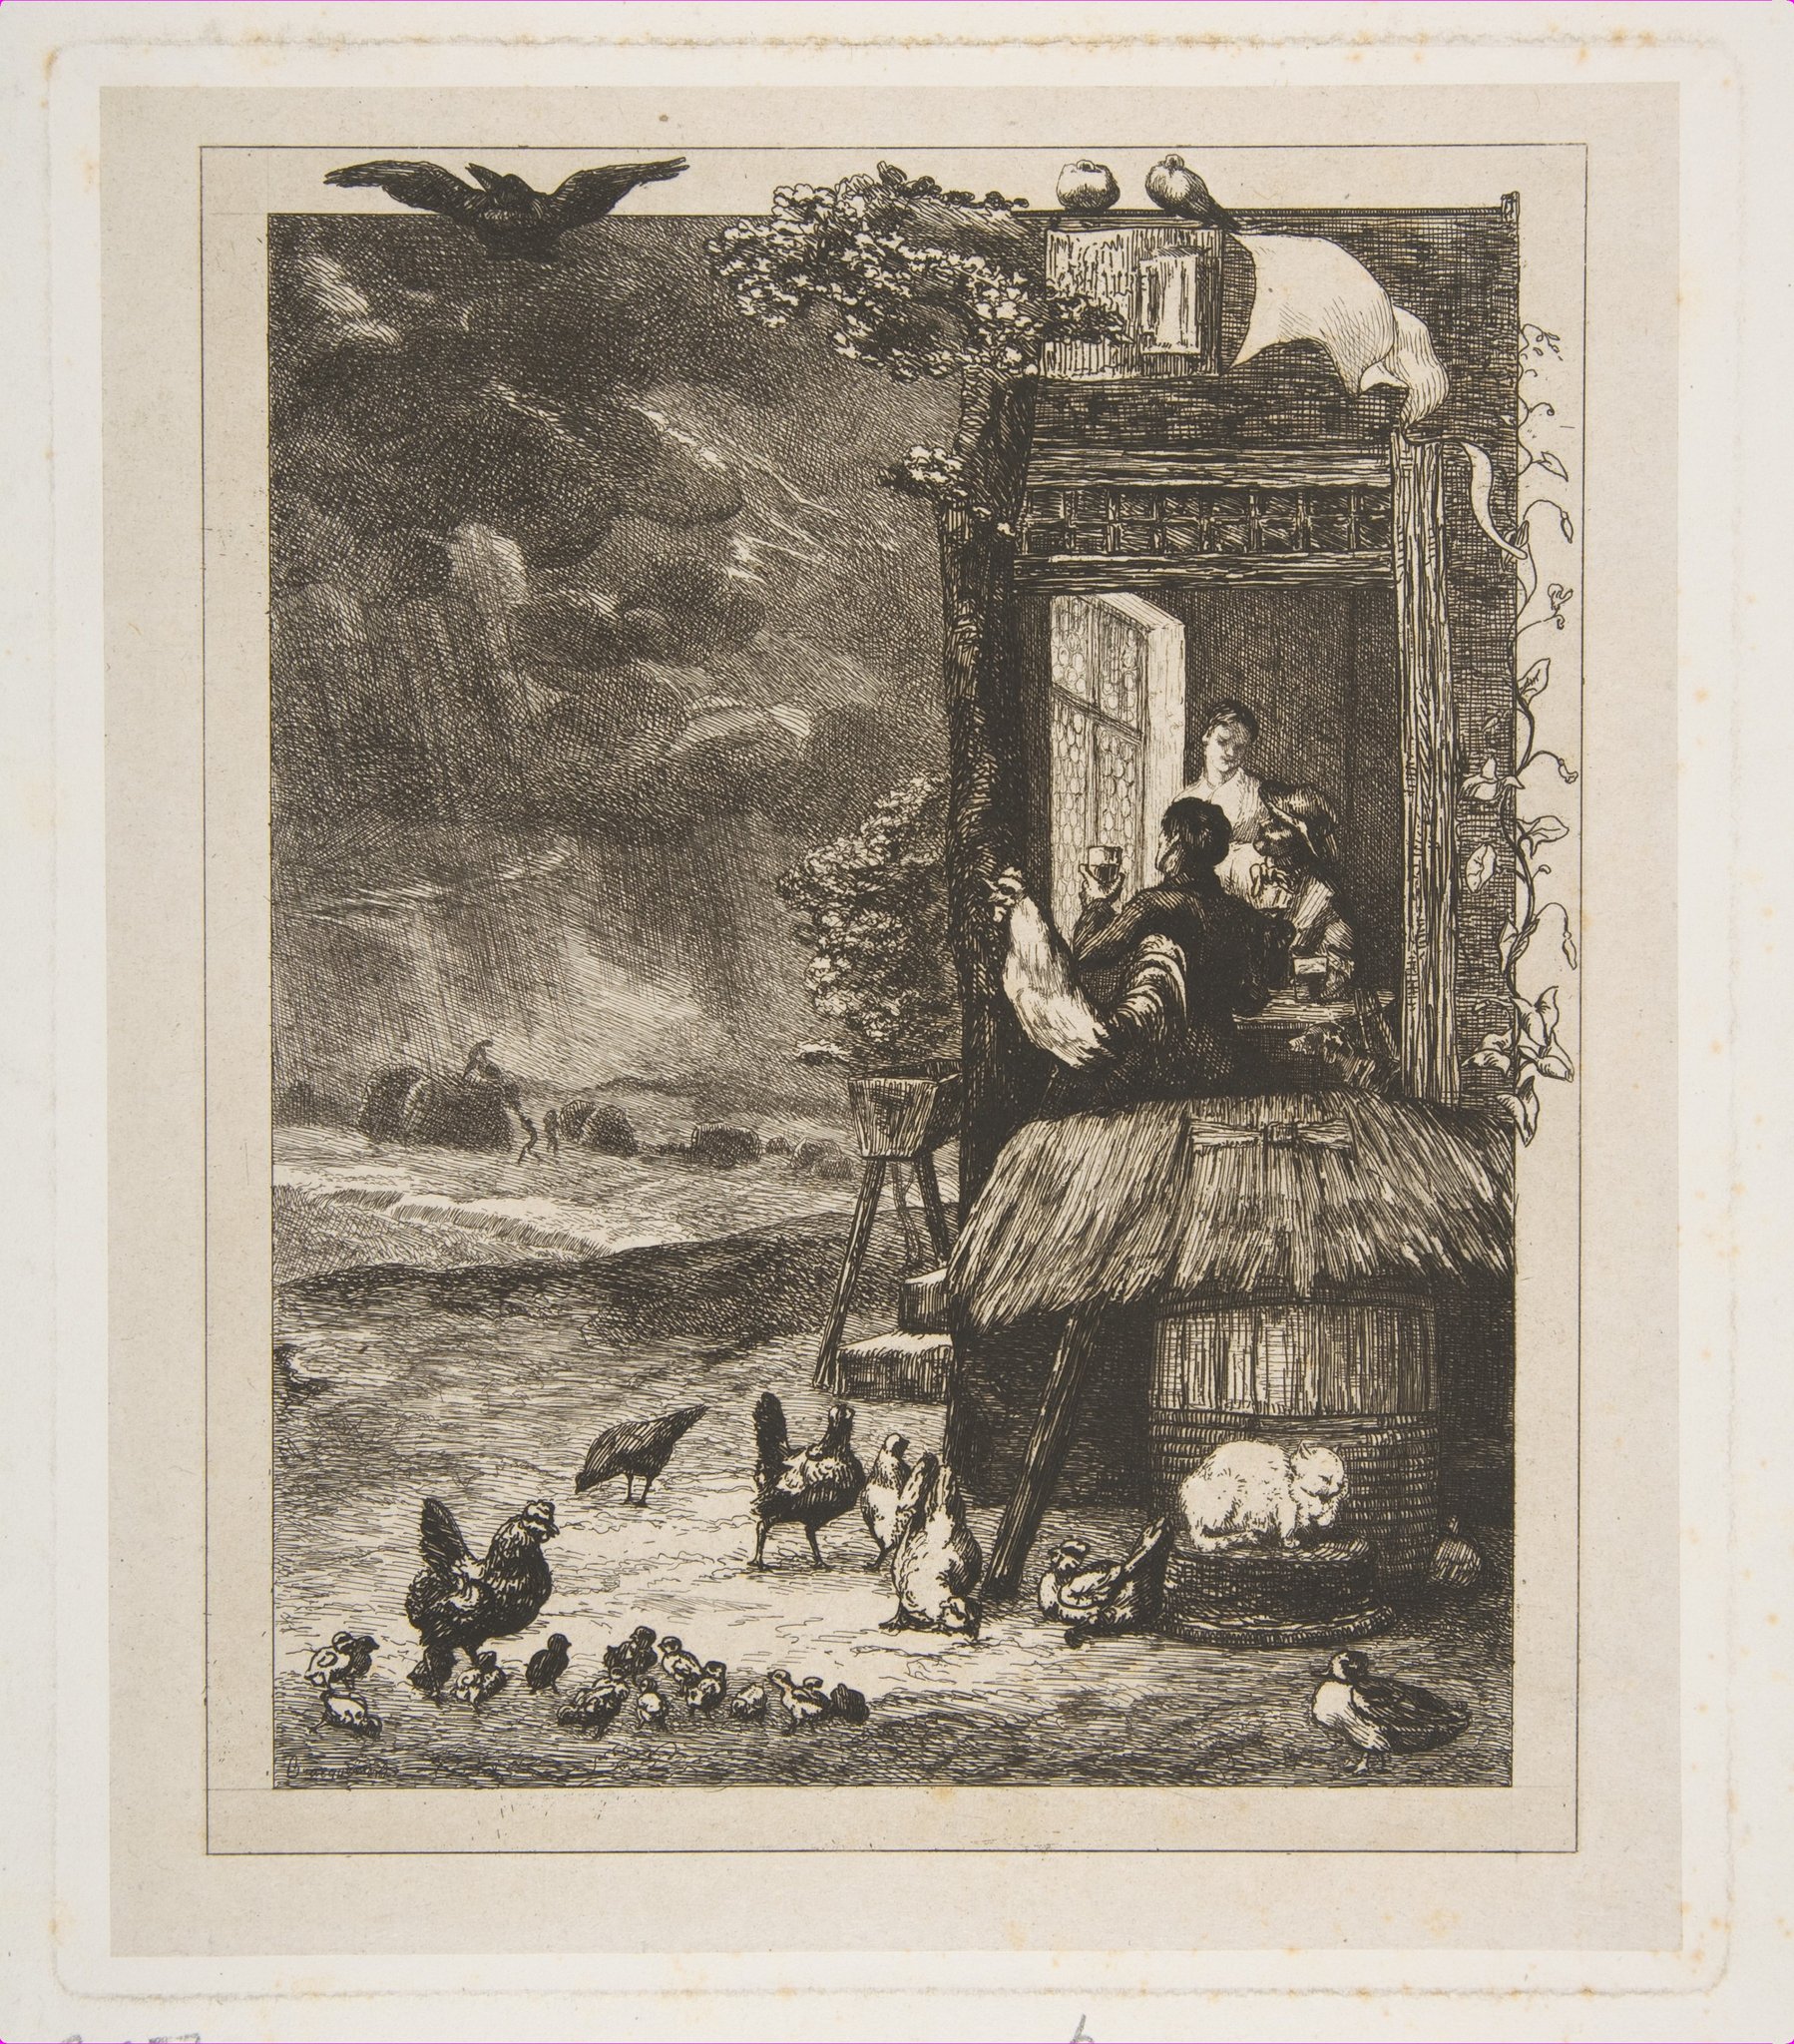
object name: print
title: L'orage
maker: félix bracquemond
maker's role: artist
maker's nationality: french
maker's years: 1833-1914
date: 1856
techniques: etching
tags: birds,chickens,farms,men,women,cats